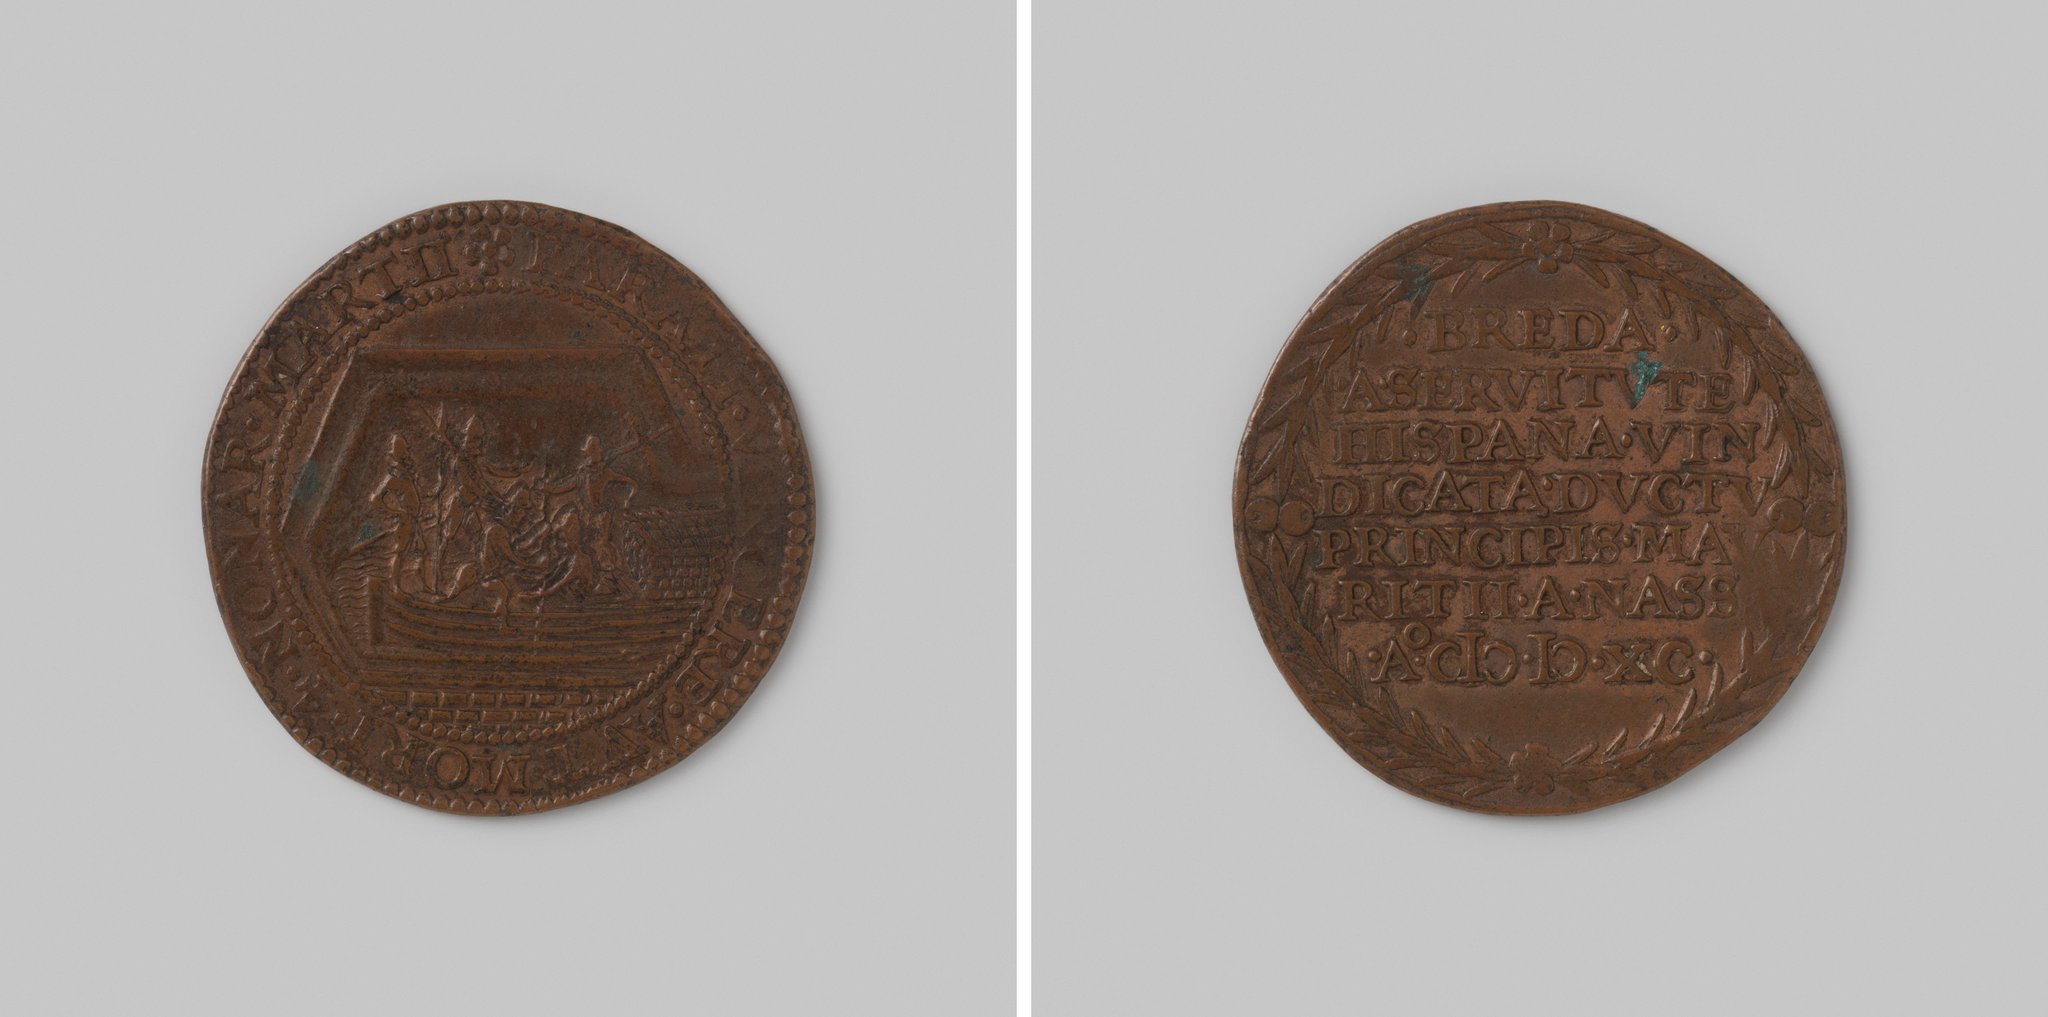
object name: history medal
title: Rekenpenning uit Dordrecht op de inname van Breda met het turfschip 1590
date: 1590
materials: copper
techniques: striking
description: Koperen penning, op de voorzijde het turfschip binnen de omwalling waaruit soldaten klimmen, met omschrift, op de keerzijde zeven regels tekst in een lauwerkrans.